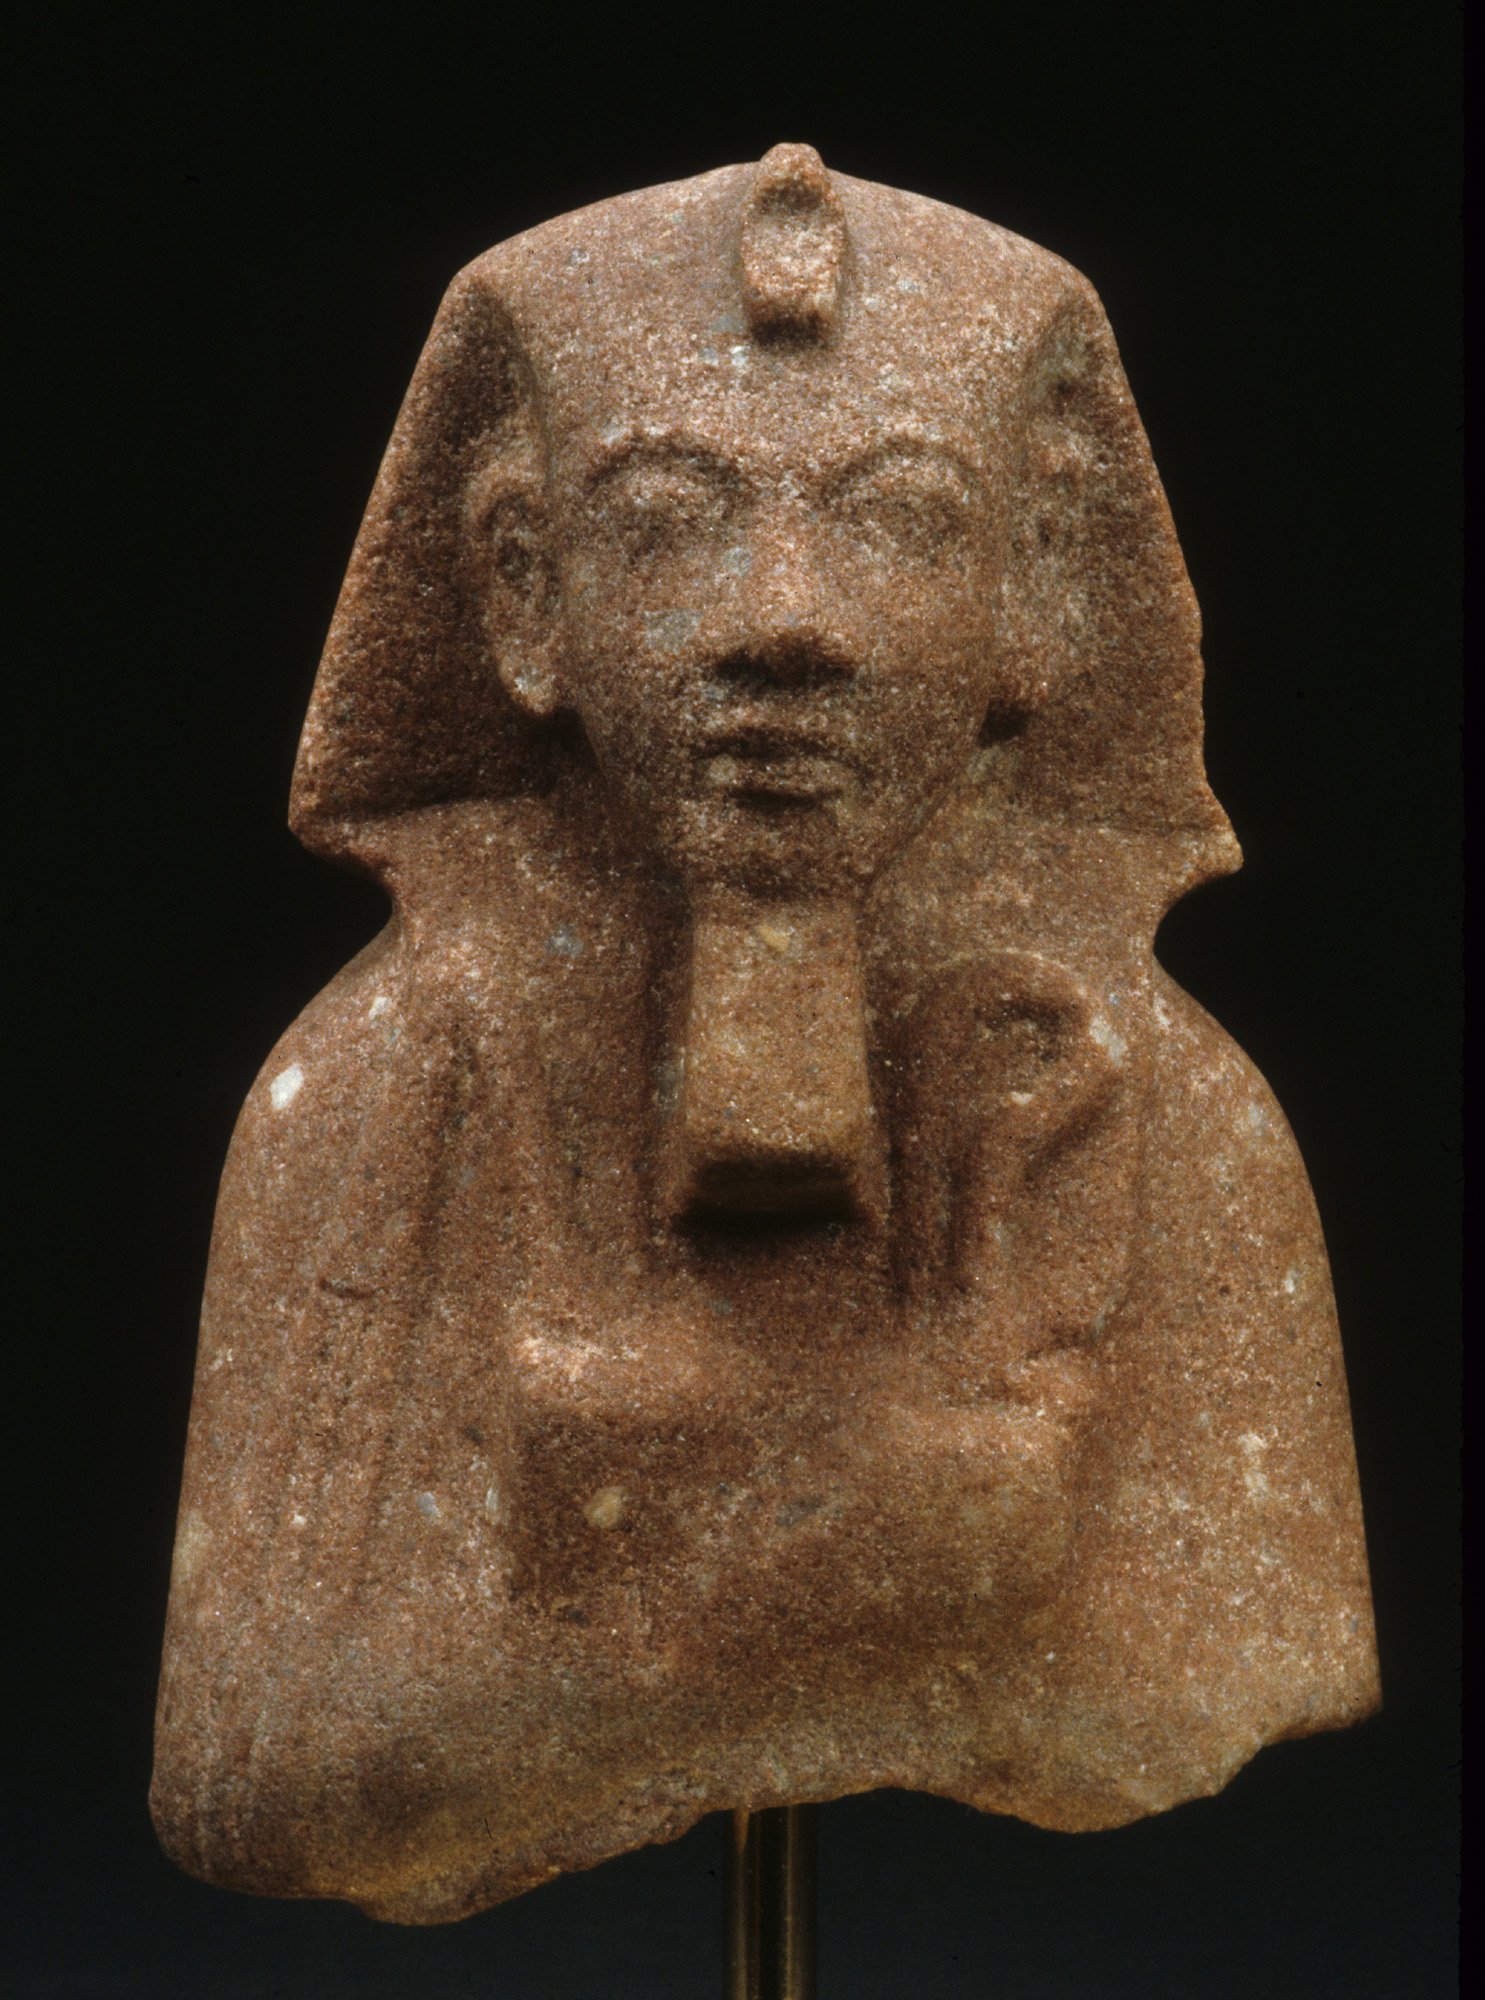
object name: funerary figure, shabti, akhenaten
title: Funerary Figure of Akhenaten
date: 1353-1336 BCE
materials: quartzite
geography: middle egypt